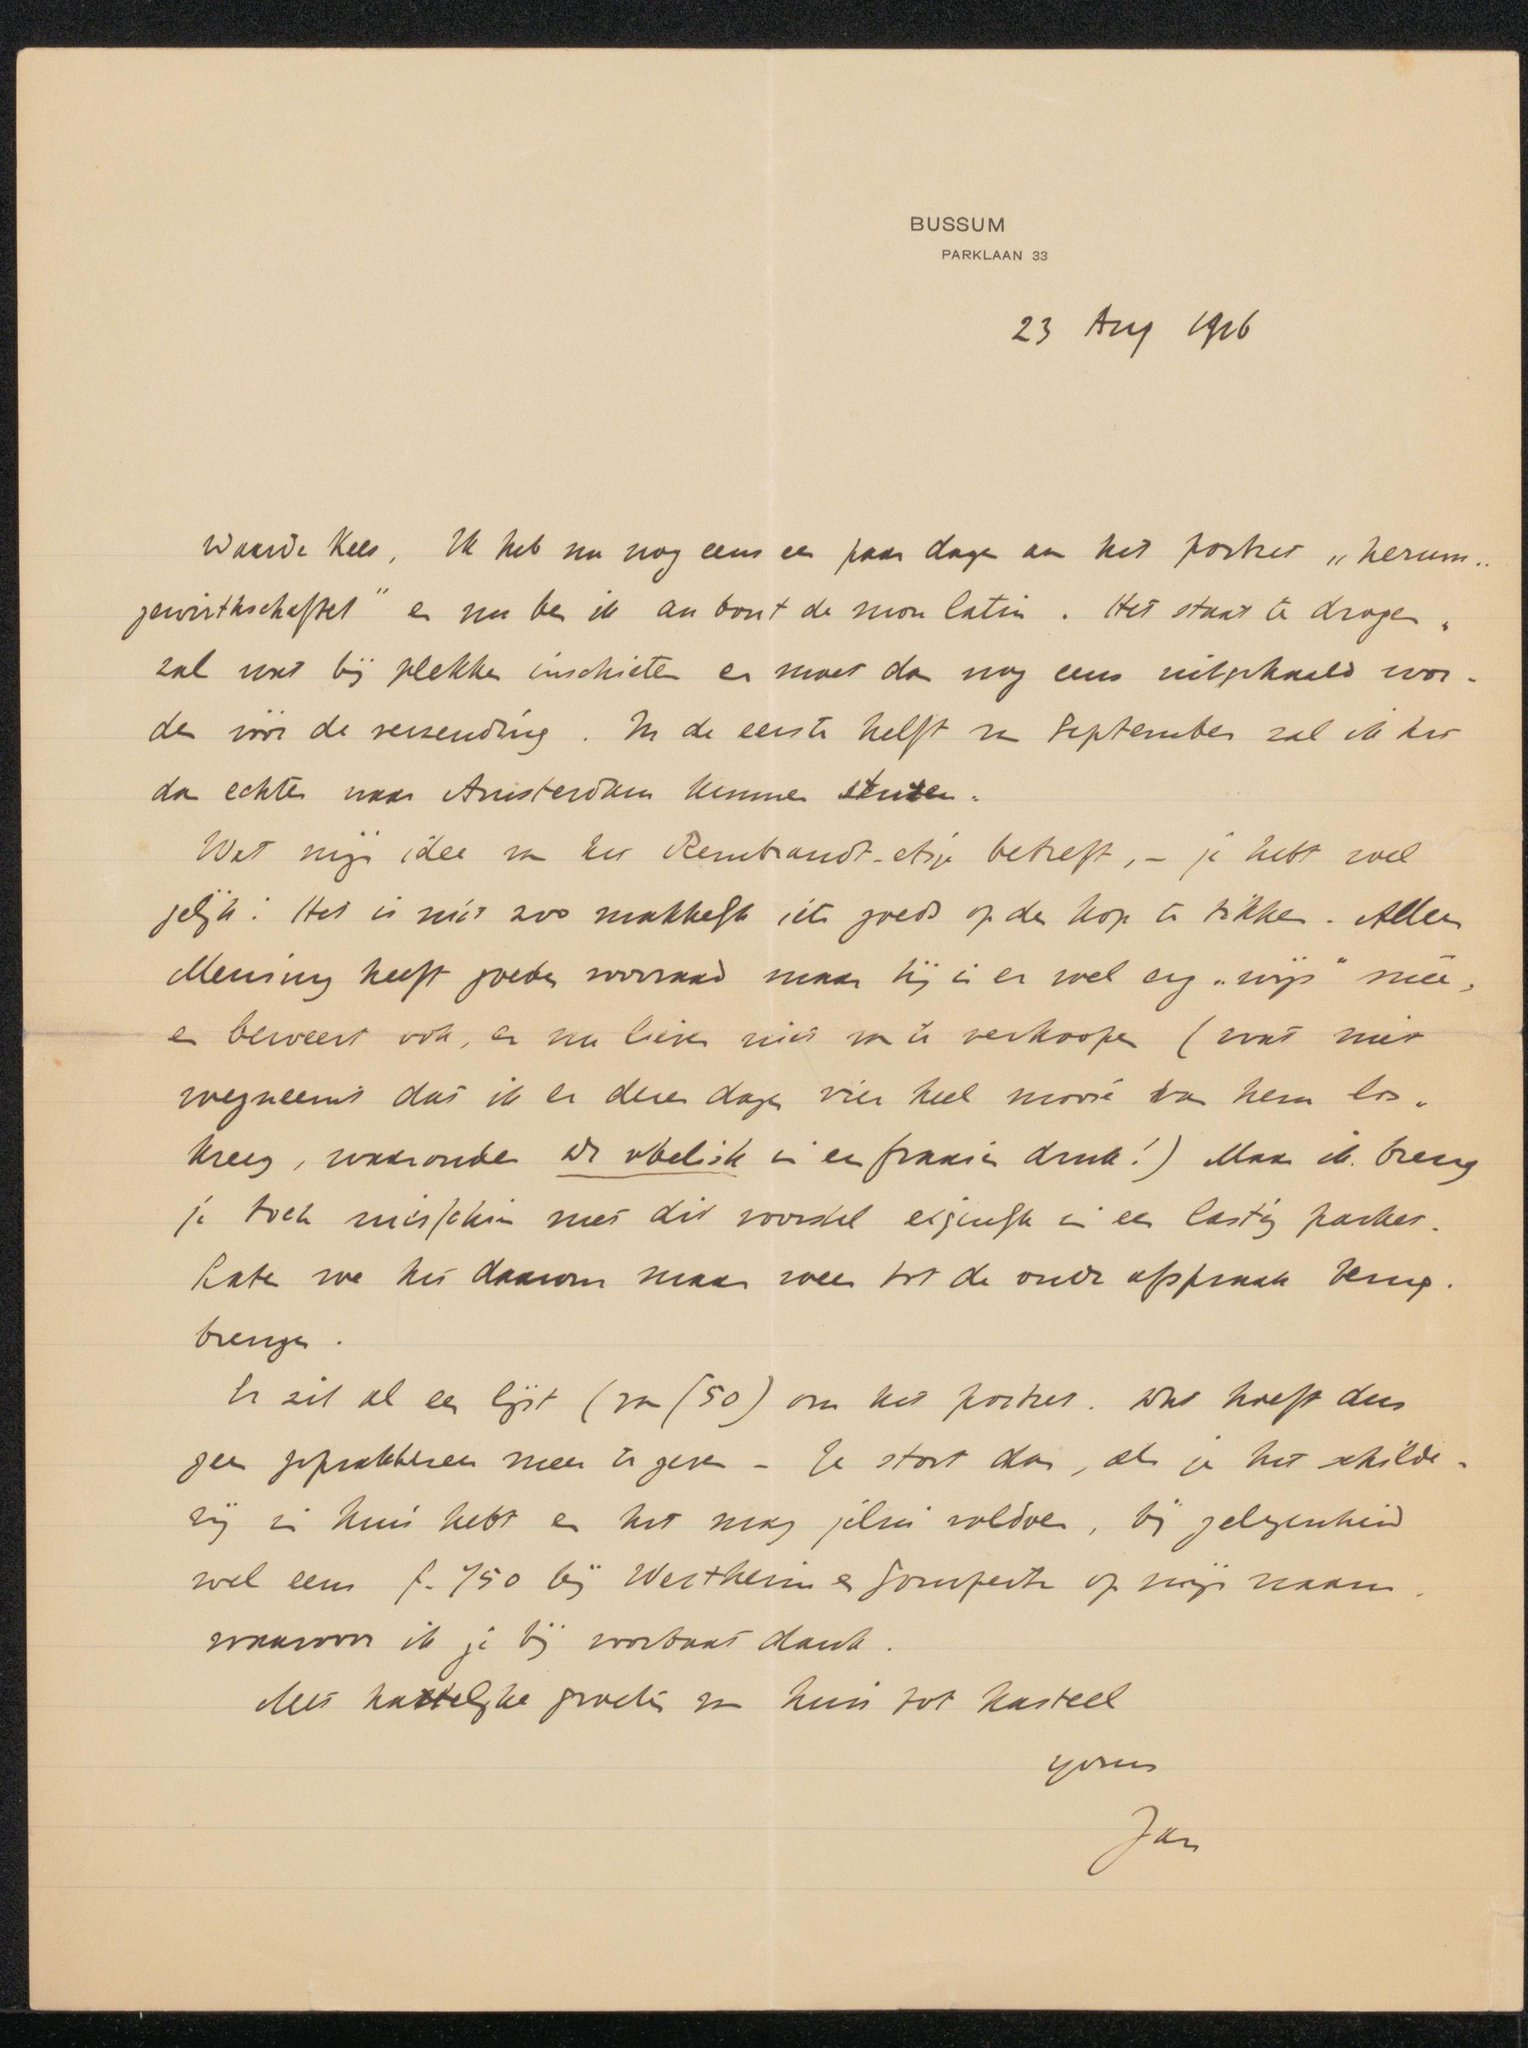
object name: letter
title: Brief aan Cornelis Gerardus 't Hooft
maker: jan veth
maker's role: designer, draughtsman, painter, print maker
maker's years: 1864-1925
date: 1916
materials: ink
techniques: pen, printing, writing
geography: bussum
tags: leiden, rembrandt van rijn, antonius wilhelmus mari mensing, dordrecht, painter, draughtsman, cornelis gerardus 't hooft, painting (including book-illumination, miniature-painting), historical persons (portraits and scenes from the life), money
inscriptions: collector's mark: ‘RPK’